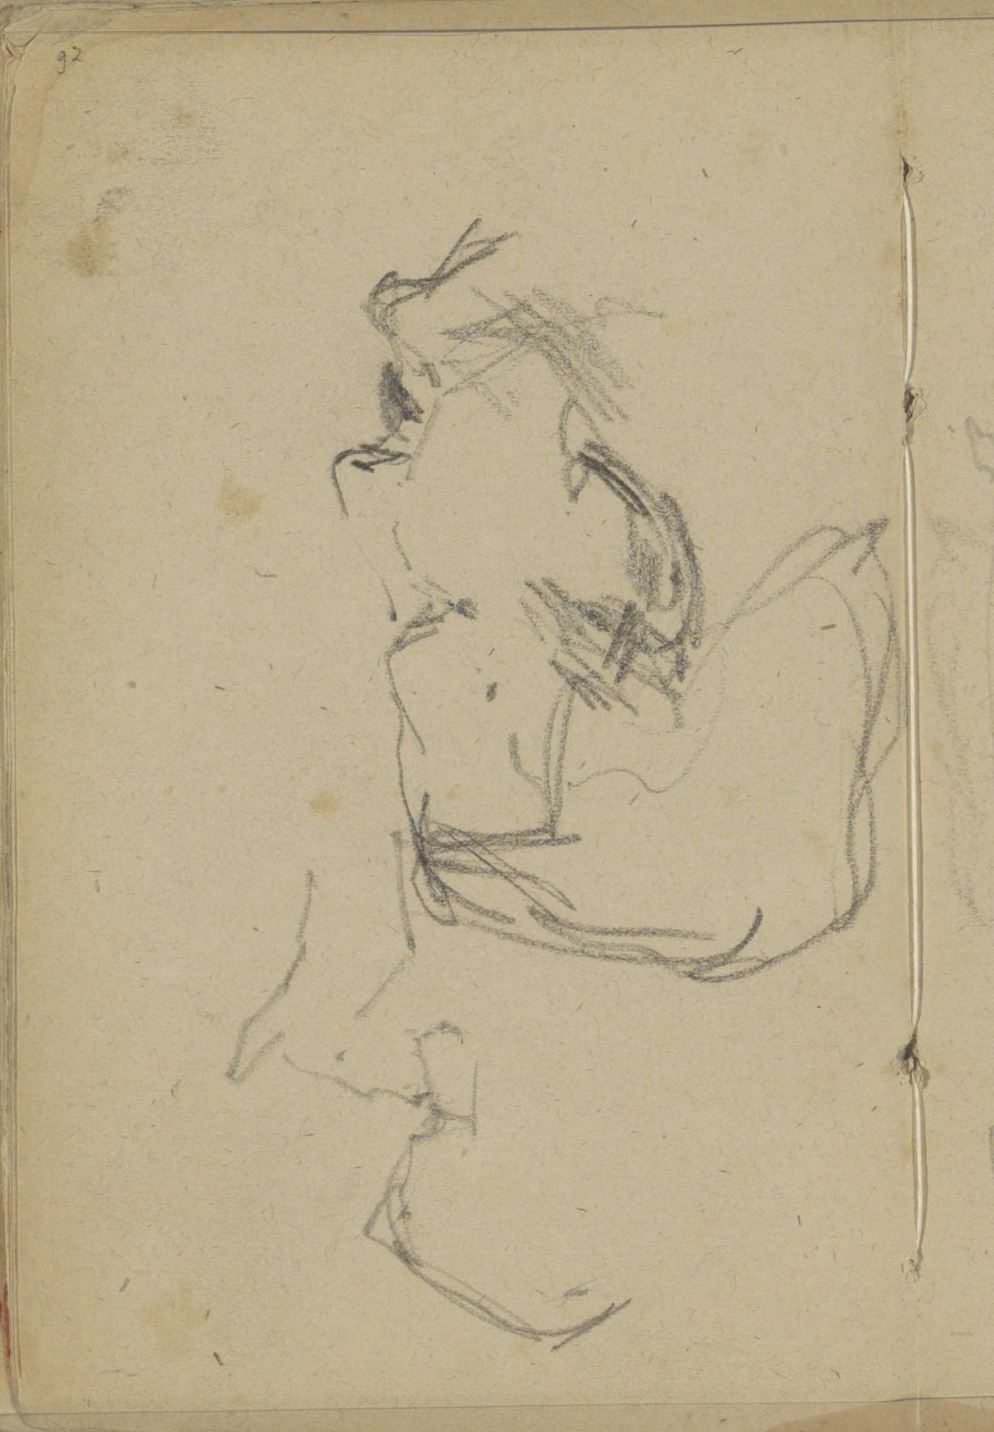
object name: sketchbook leaf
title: Portret van een onbekende man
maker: george hendrik breitner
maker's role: draughtsman, painter, print maker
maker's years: 1857-1923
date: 1881-1883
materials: chalk, paper, pencil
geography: south holland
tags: head (human) (+ sideview, profile), anonymous historical person portrayed (+ profile portrait)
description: Portret van een onbekende man, in profiel naar rechts. Pagina 92 uit een schetsboek met 70 bladen.